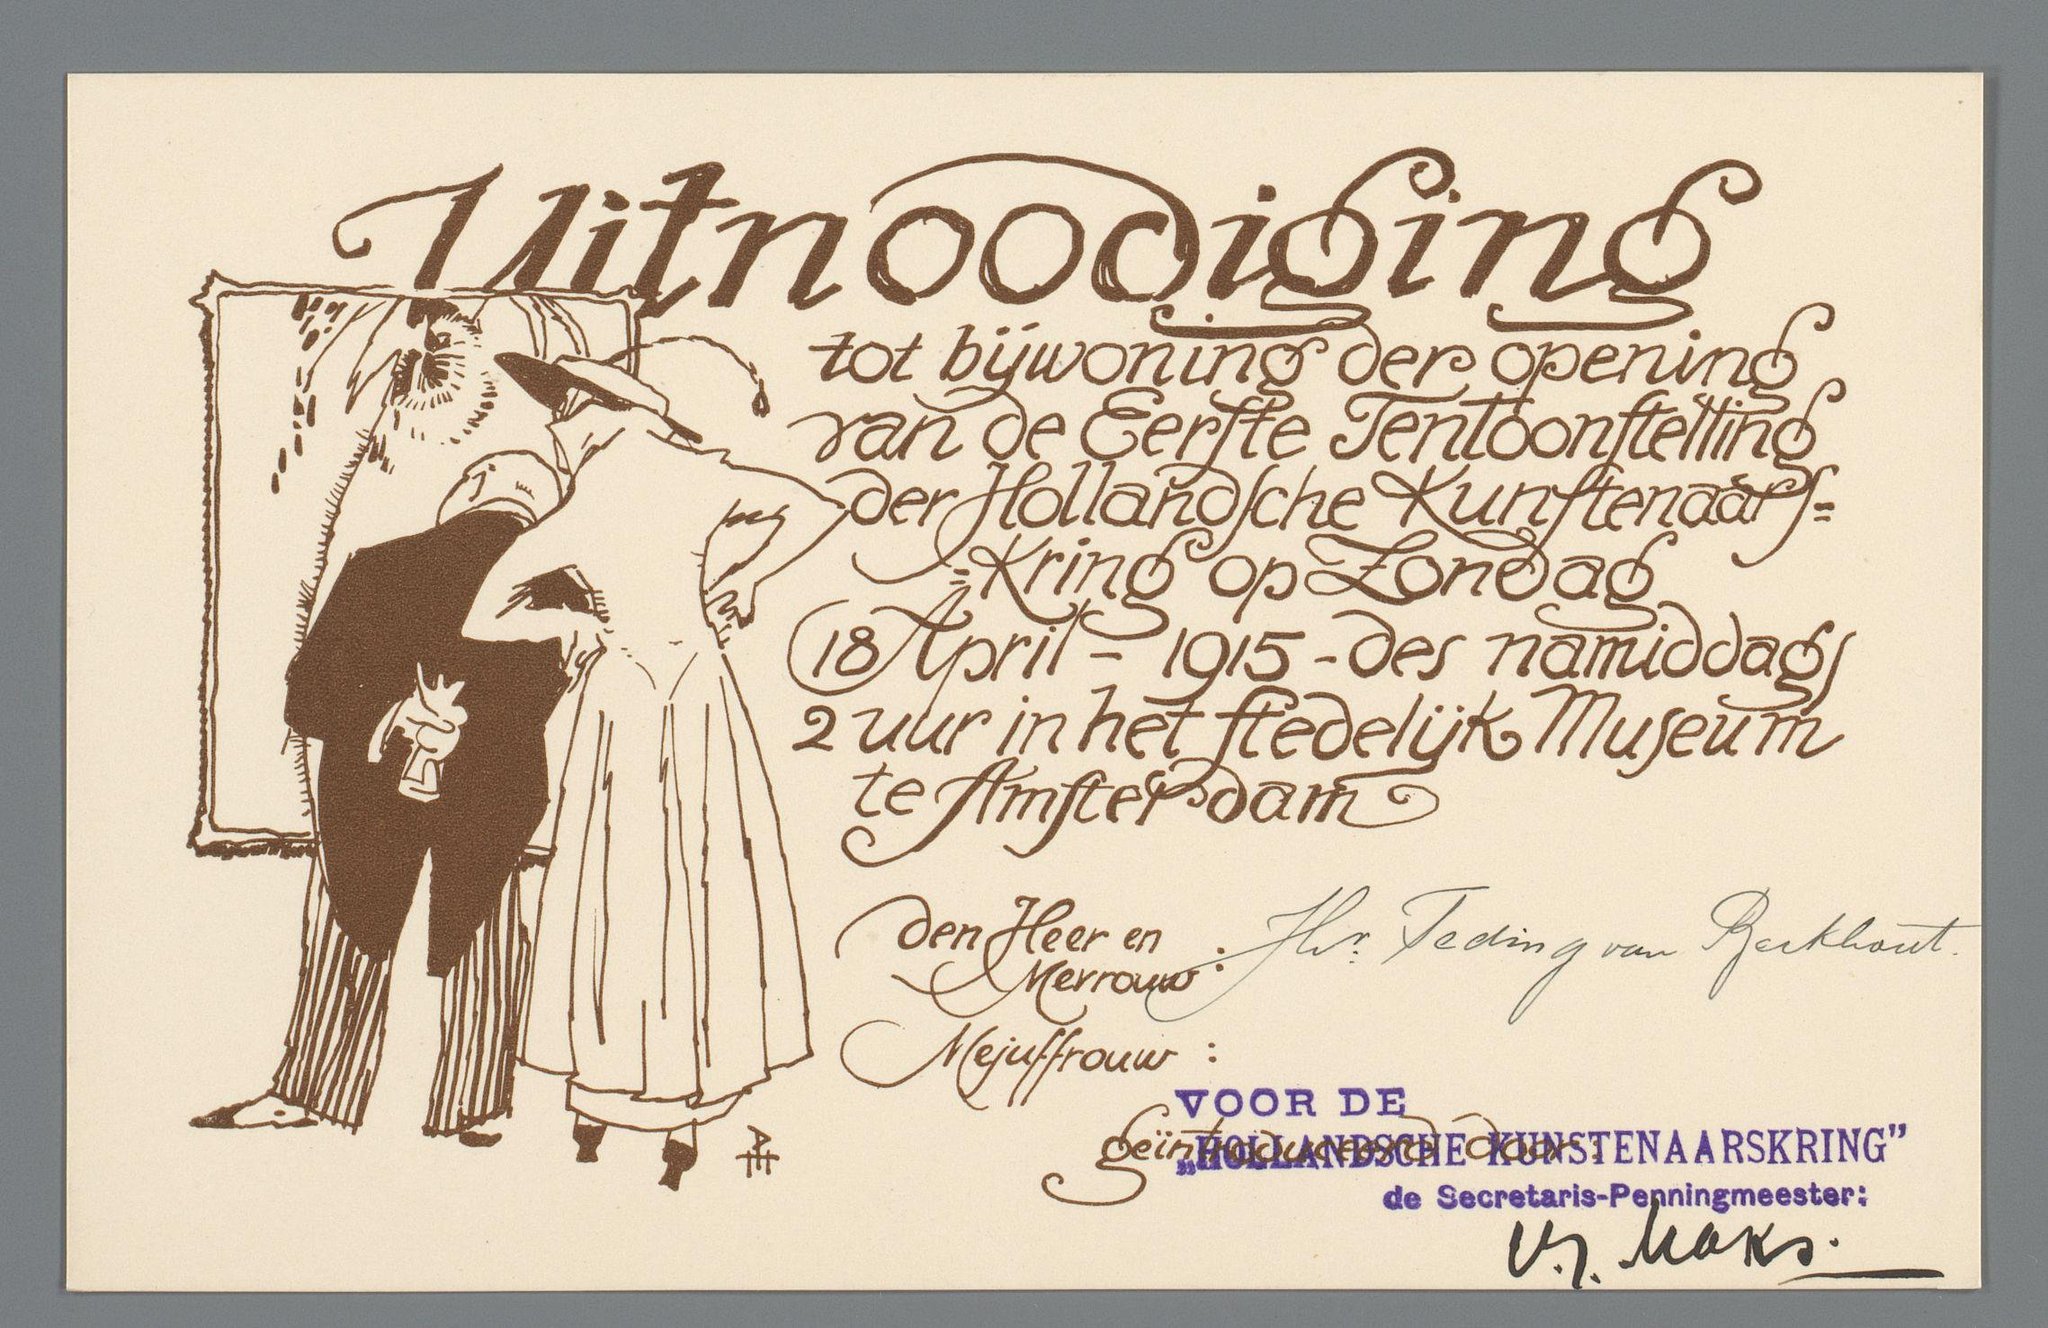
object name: photomechanical print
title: Uitnodiging voor de opening van de Eerste Tentoonstelling der Hollandsche Kunstenaarskring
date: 1915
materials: paper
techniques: printing block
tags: amsterdam, kees maks, picture, painting, collection, exhibition, show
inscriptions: stamp: ‘Voor de 'Hollandsche Kunstenaarskring' de Secretaris-Penningmeester’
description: Een man en vrouw staan een schilderij te bestuderen. Daarnaast de tekst: 'Uitnoodiging tot bijwoning der opening van de Eerste Tentoonstelling der Hollandsche Kunstenaarskring op Zondag 18 april 1915 des namiddags 2 uur in het Stedelijk Museum te Amsterdam. Daaronder is in handschrift de geadresseerde van deze uitnodiging ingevuld (Jhr. Teding van Berkhout), en daaronder de afzender, C.J. Maks, secretaris-penningmeester van de Hollandsche Kunstenaarskring.